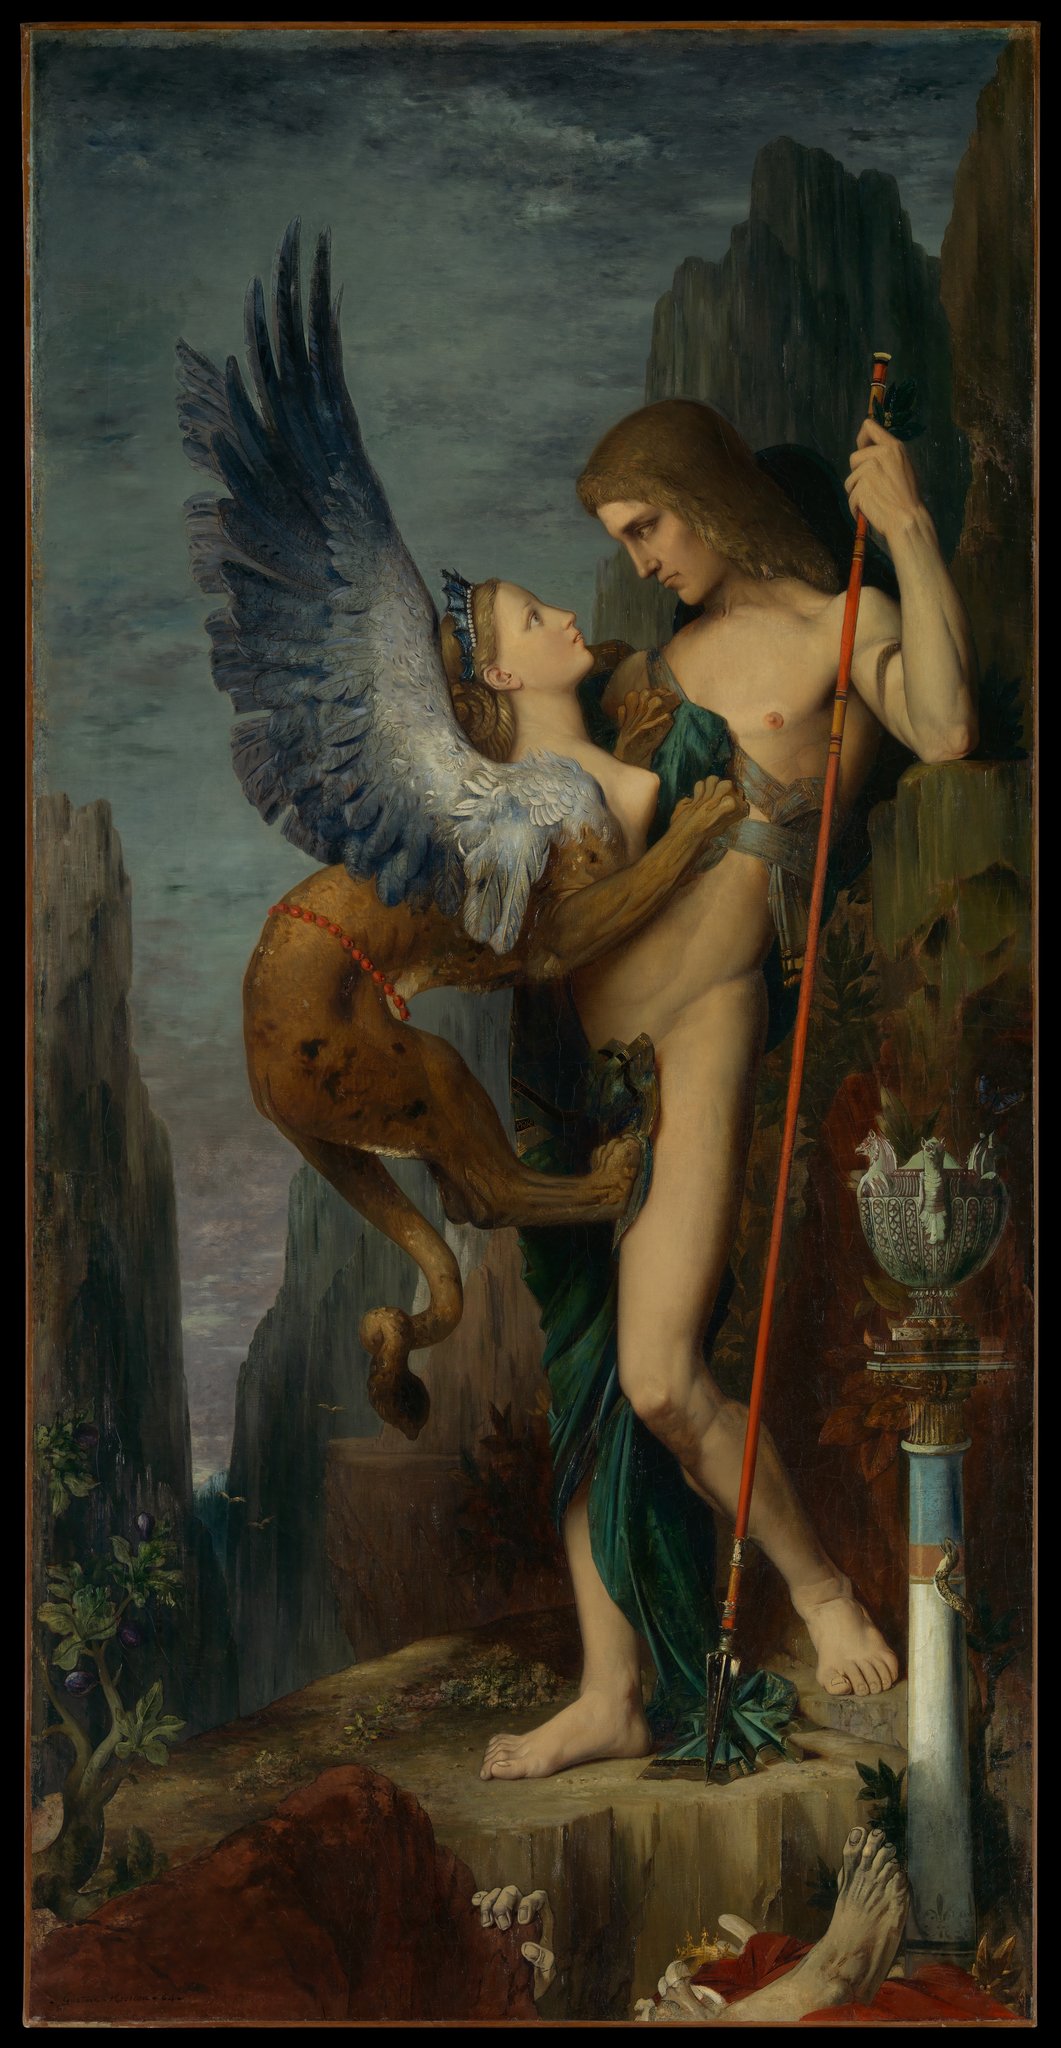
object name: painting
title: Oedipus and the Sphinx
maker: gustave moreau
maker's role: artist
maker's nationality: french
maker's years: 1826-1898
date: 1864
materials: canvas, oil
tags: men,oedipus,sphinx